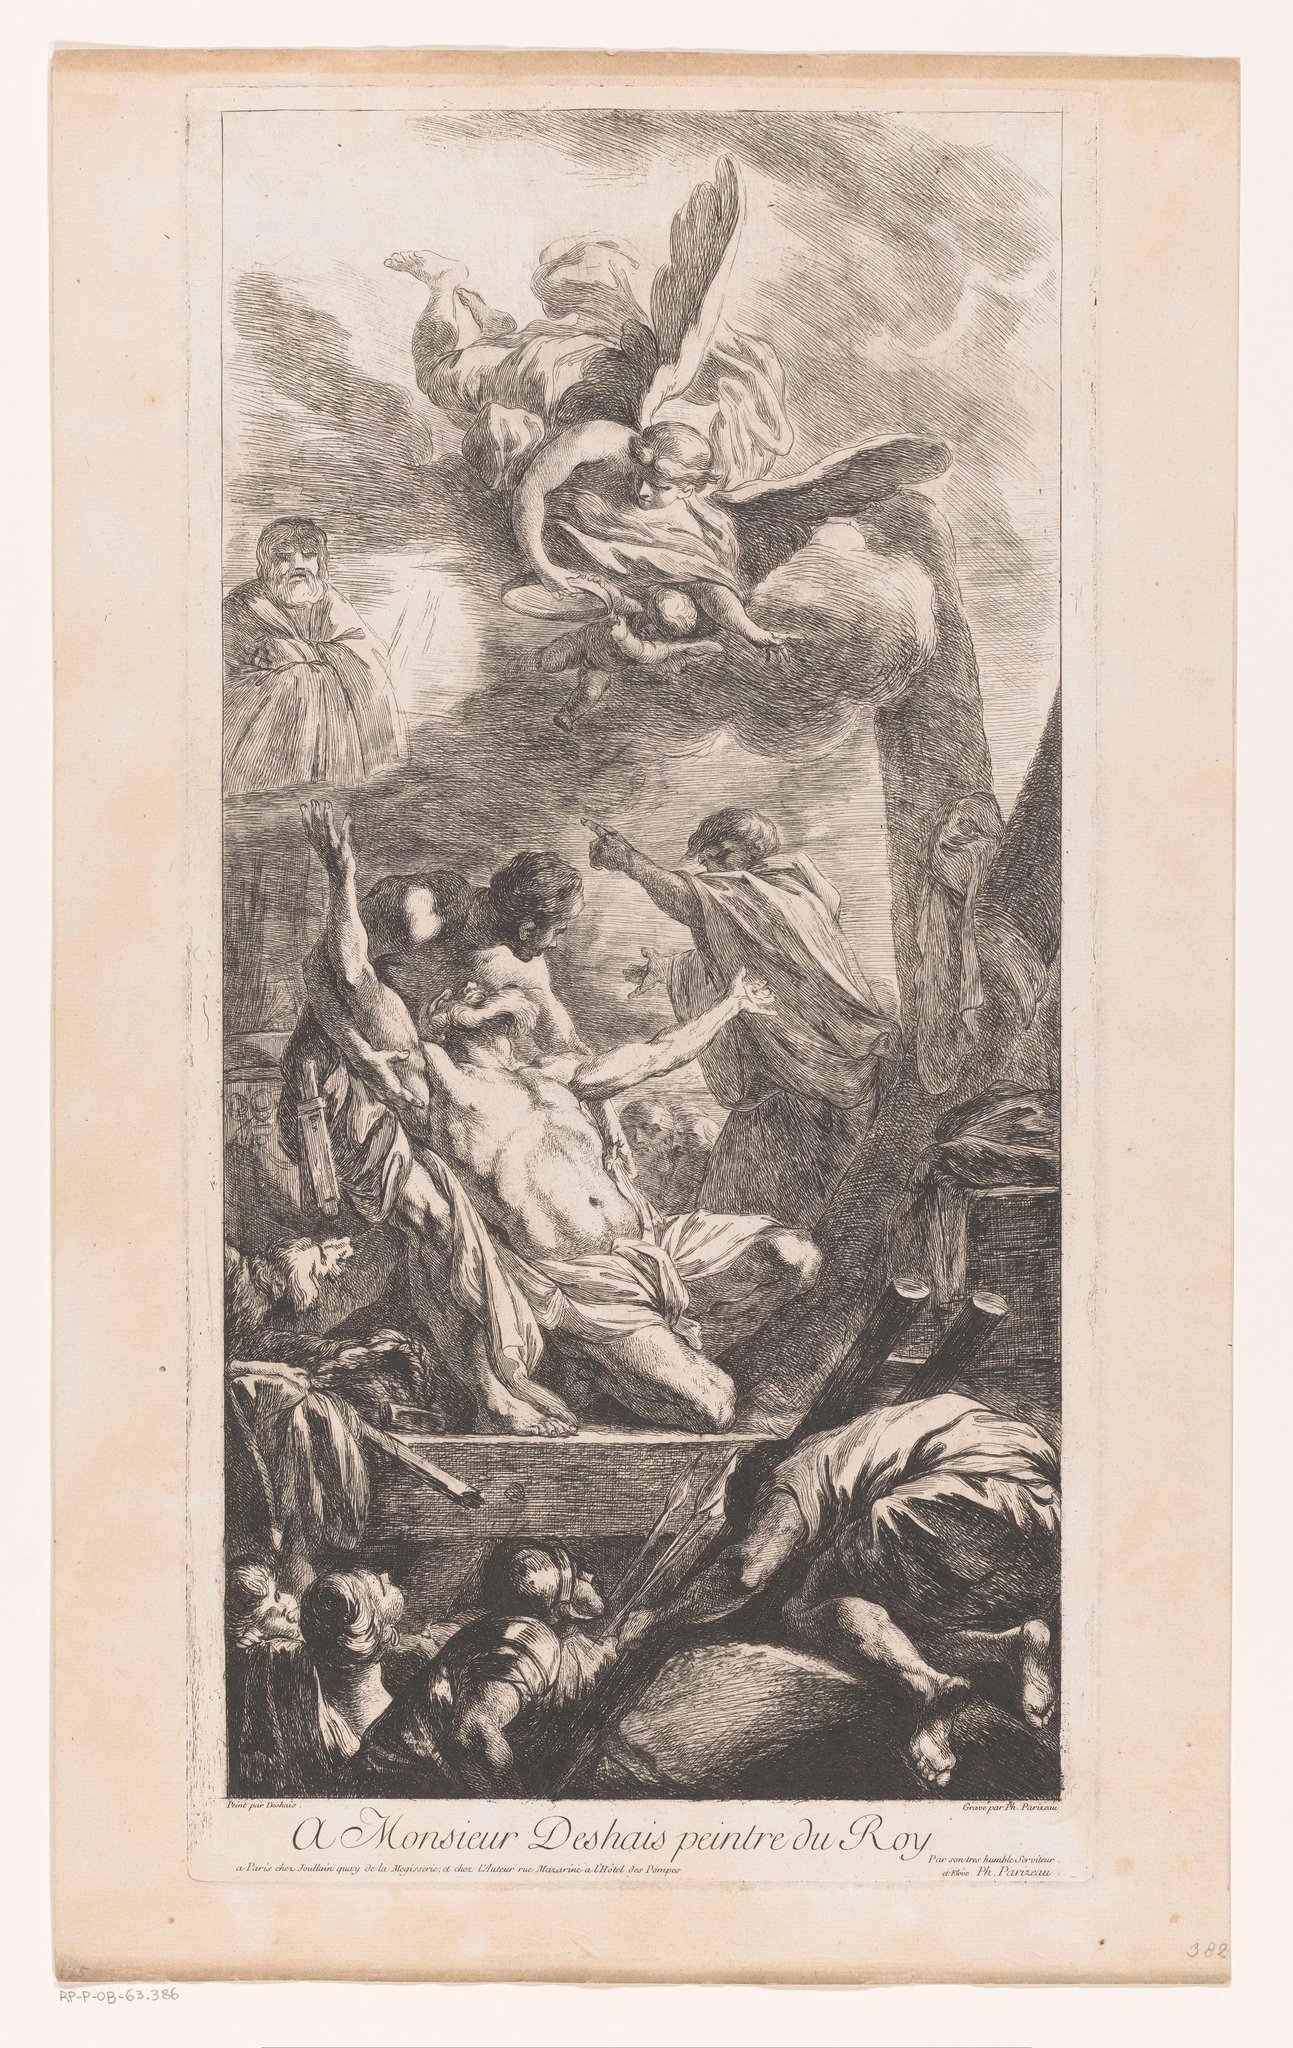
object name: print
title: Martelaarschap van de heilige Andreas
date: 1750-1801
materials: paper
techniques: etching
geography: paris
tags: crucifixion of andrew: he is undressed and tied to the cross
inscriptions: collector's mark: Lugt 240